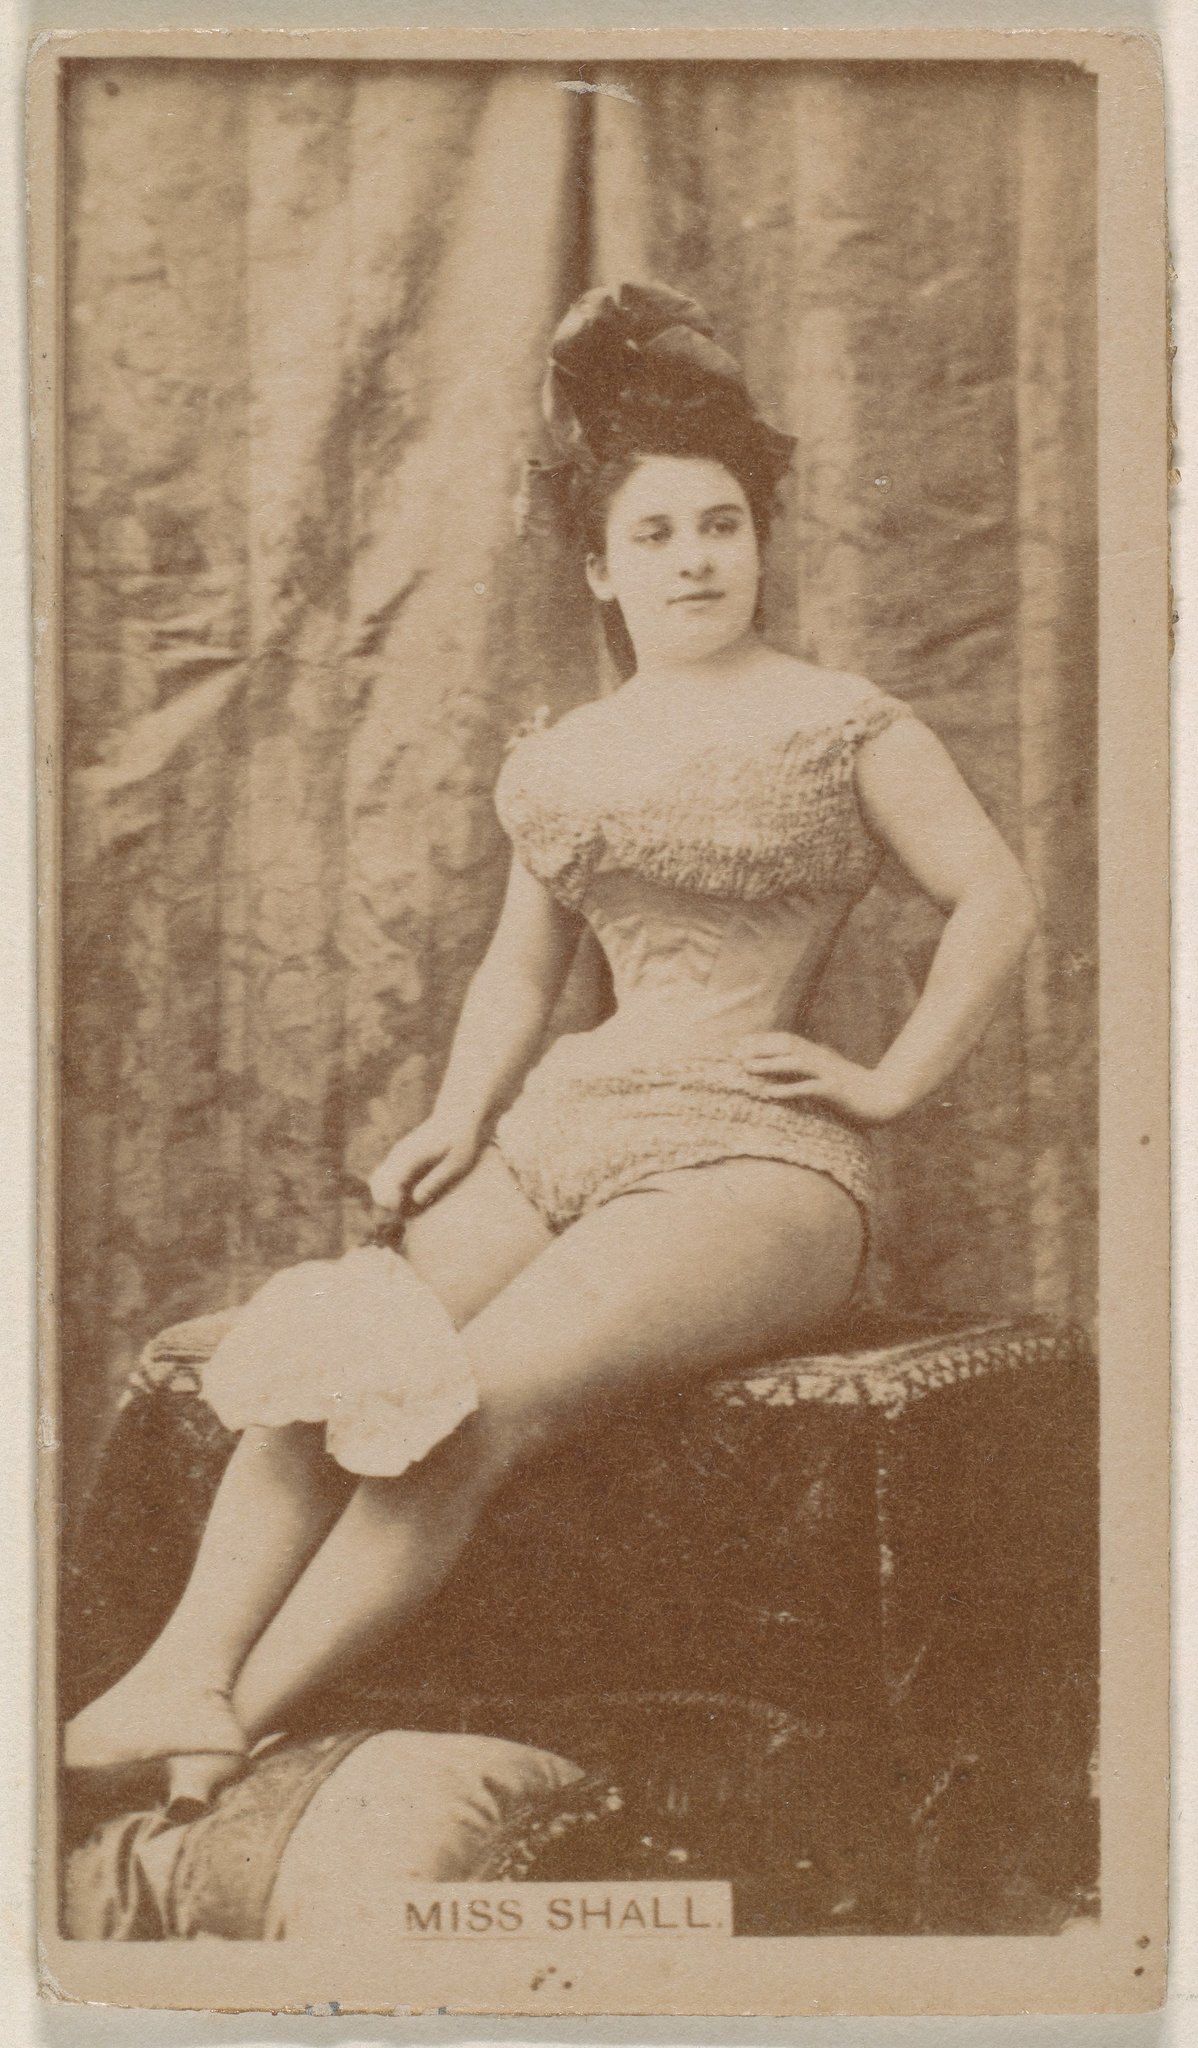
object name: photograph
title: Miss Shall, from the Actresses series (N245) issued by Kinney Brothers to promote Sweet Caporal Cigarettes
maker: kinney brothers tobacco company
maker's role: publisher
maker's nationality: american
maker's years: 1869-2011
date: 1890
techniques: albumen silver print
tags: portraits,women,actresses